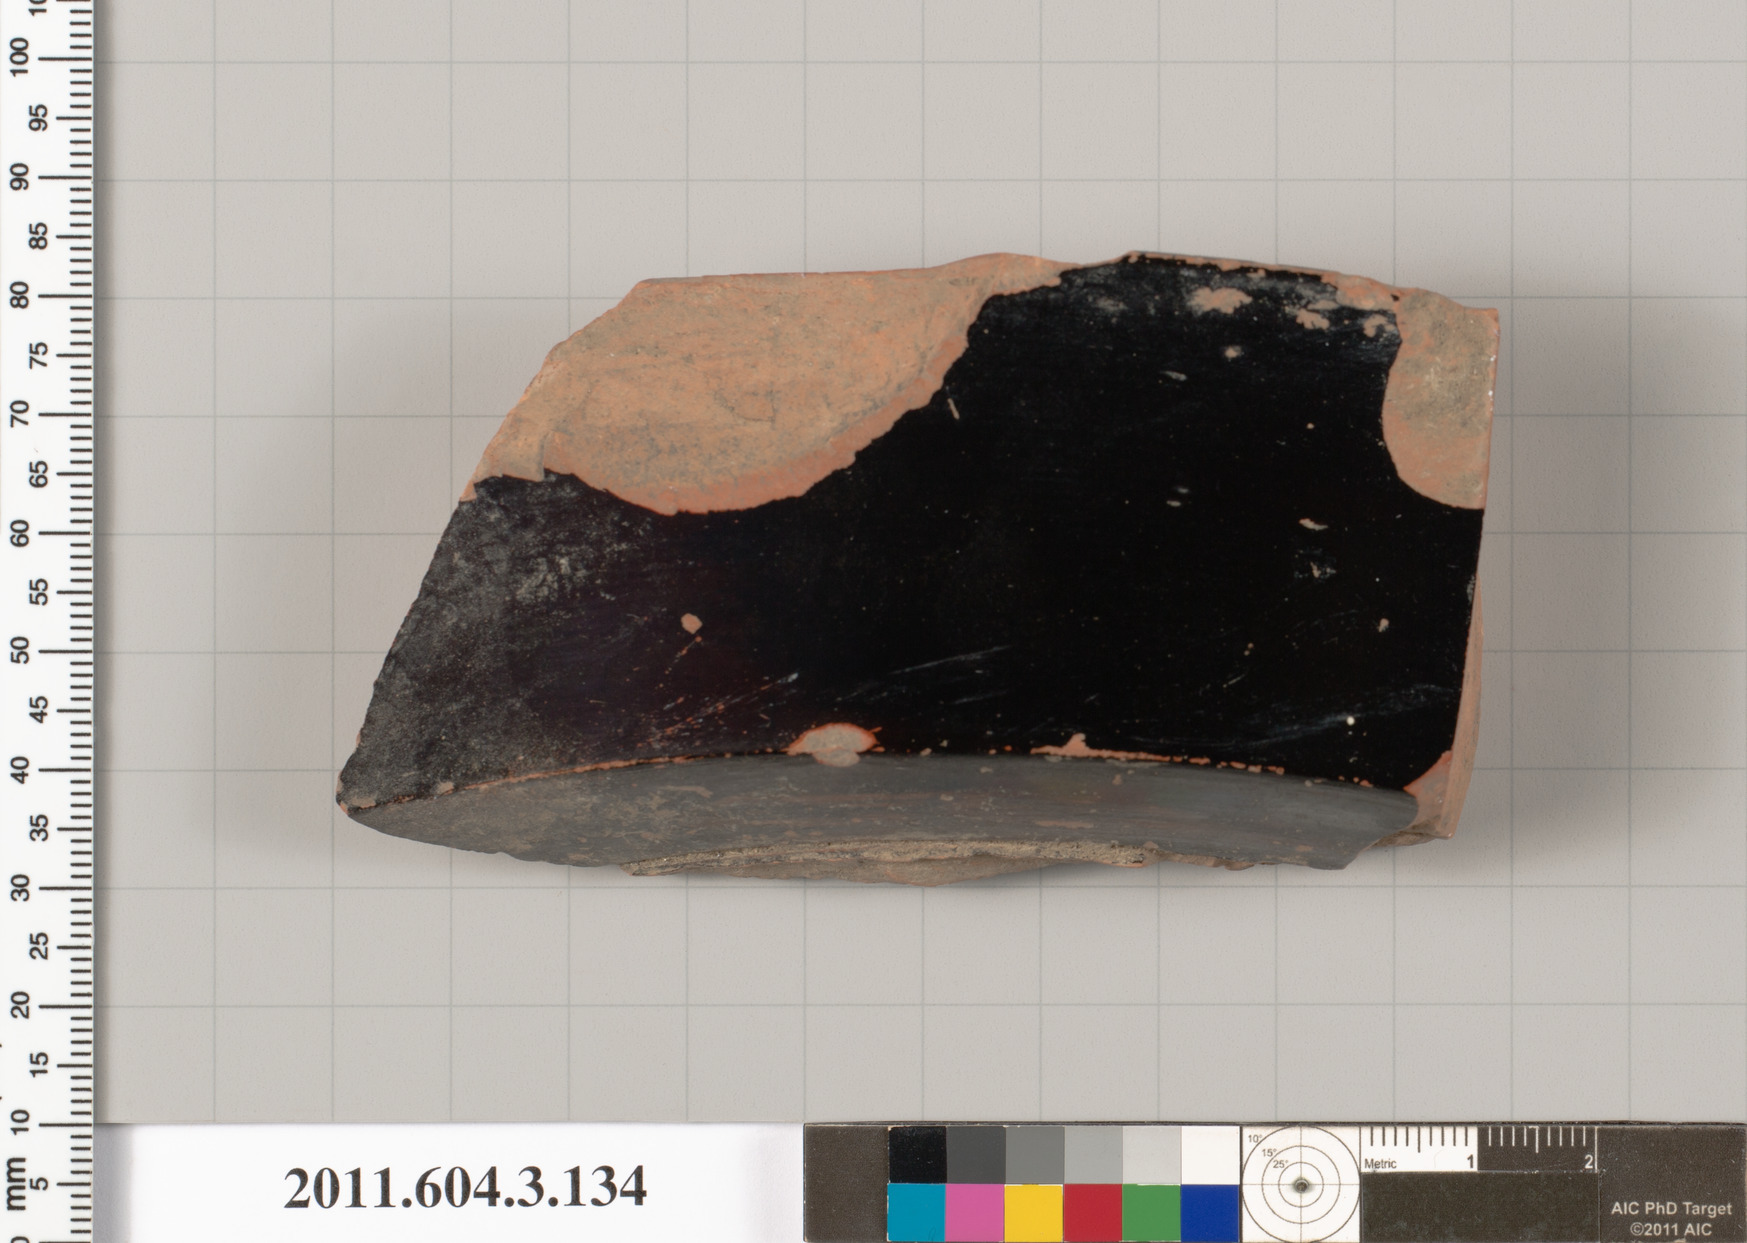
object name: amphora fragment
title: Terracotta fragment of an amphora (jar)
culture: greek, attic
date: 525-501 BCE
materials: terracotta